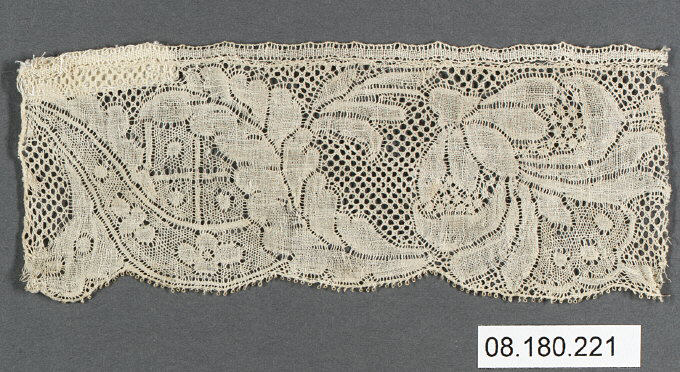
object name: fragment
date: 1701-1733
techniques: lace